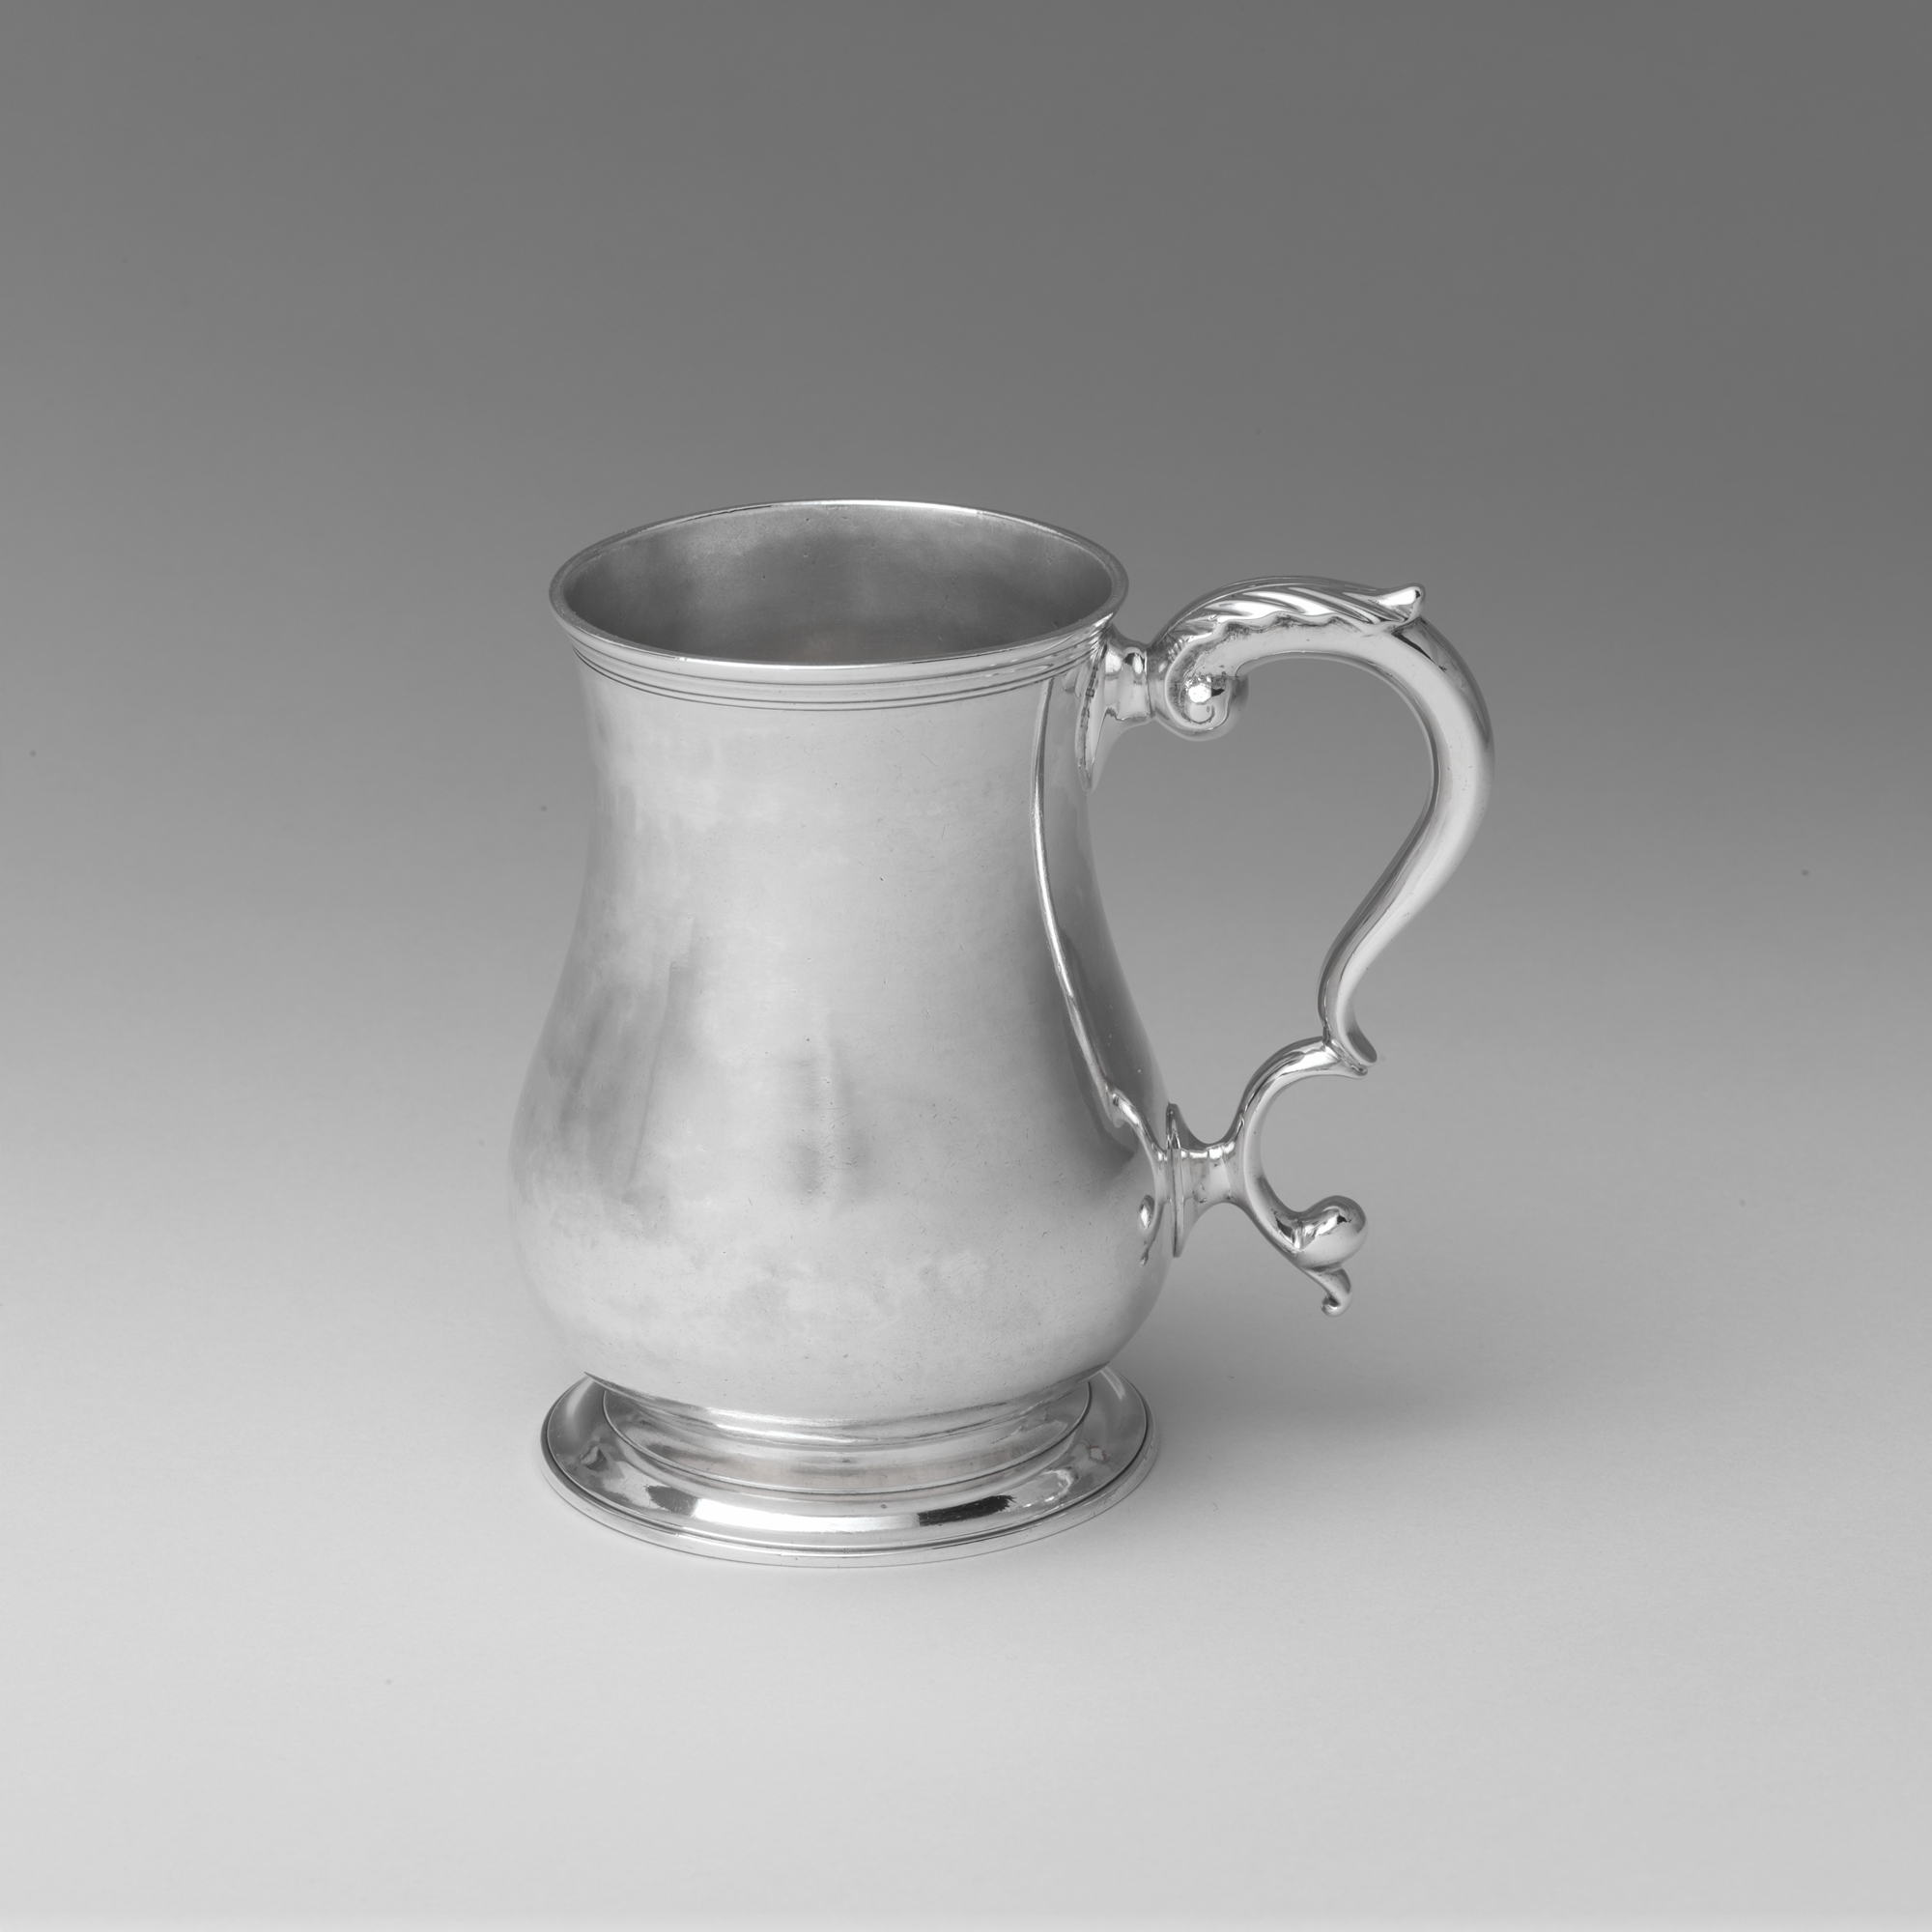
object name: cann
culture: american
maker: samuel minott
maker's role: maker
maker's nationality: american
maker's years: 1732-1803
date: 1765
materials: silver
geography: united states